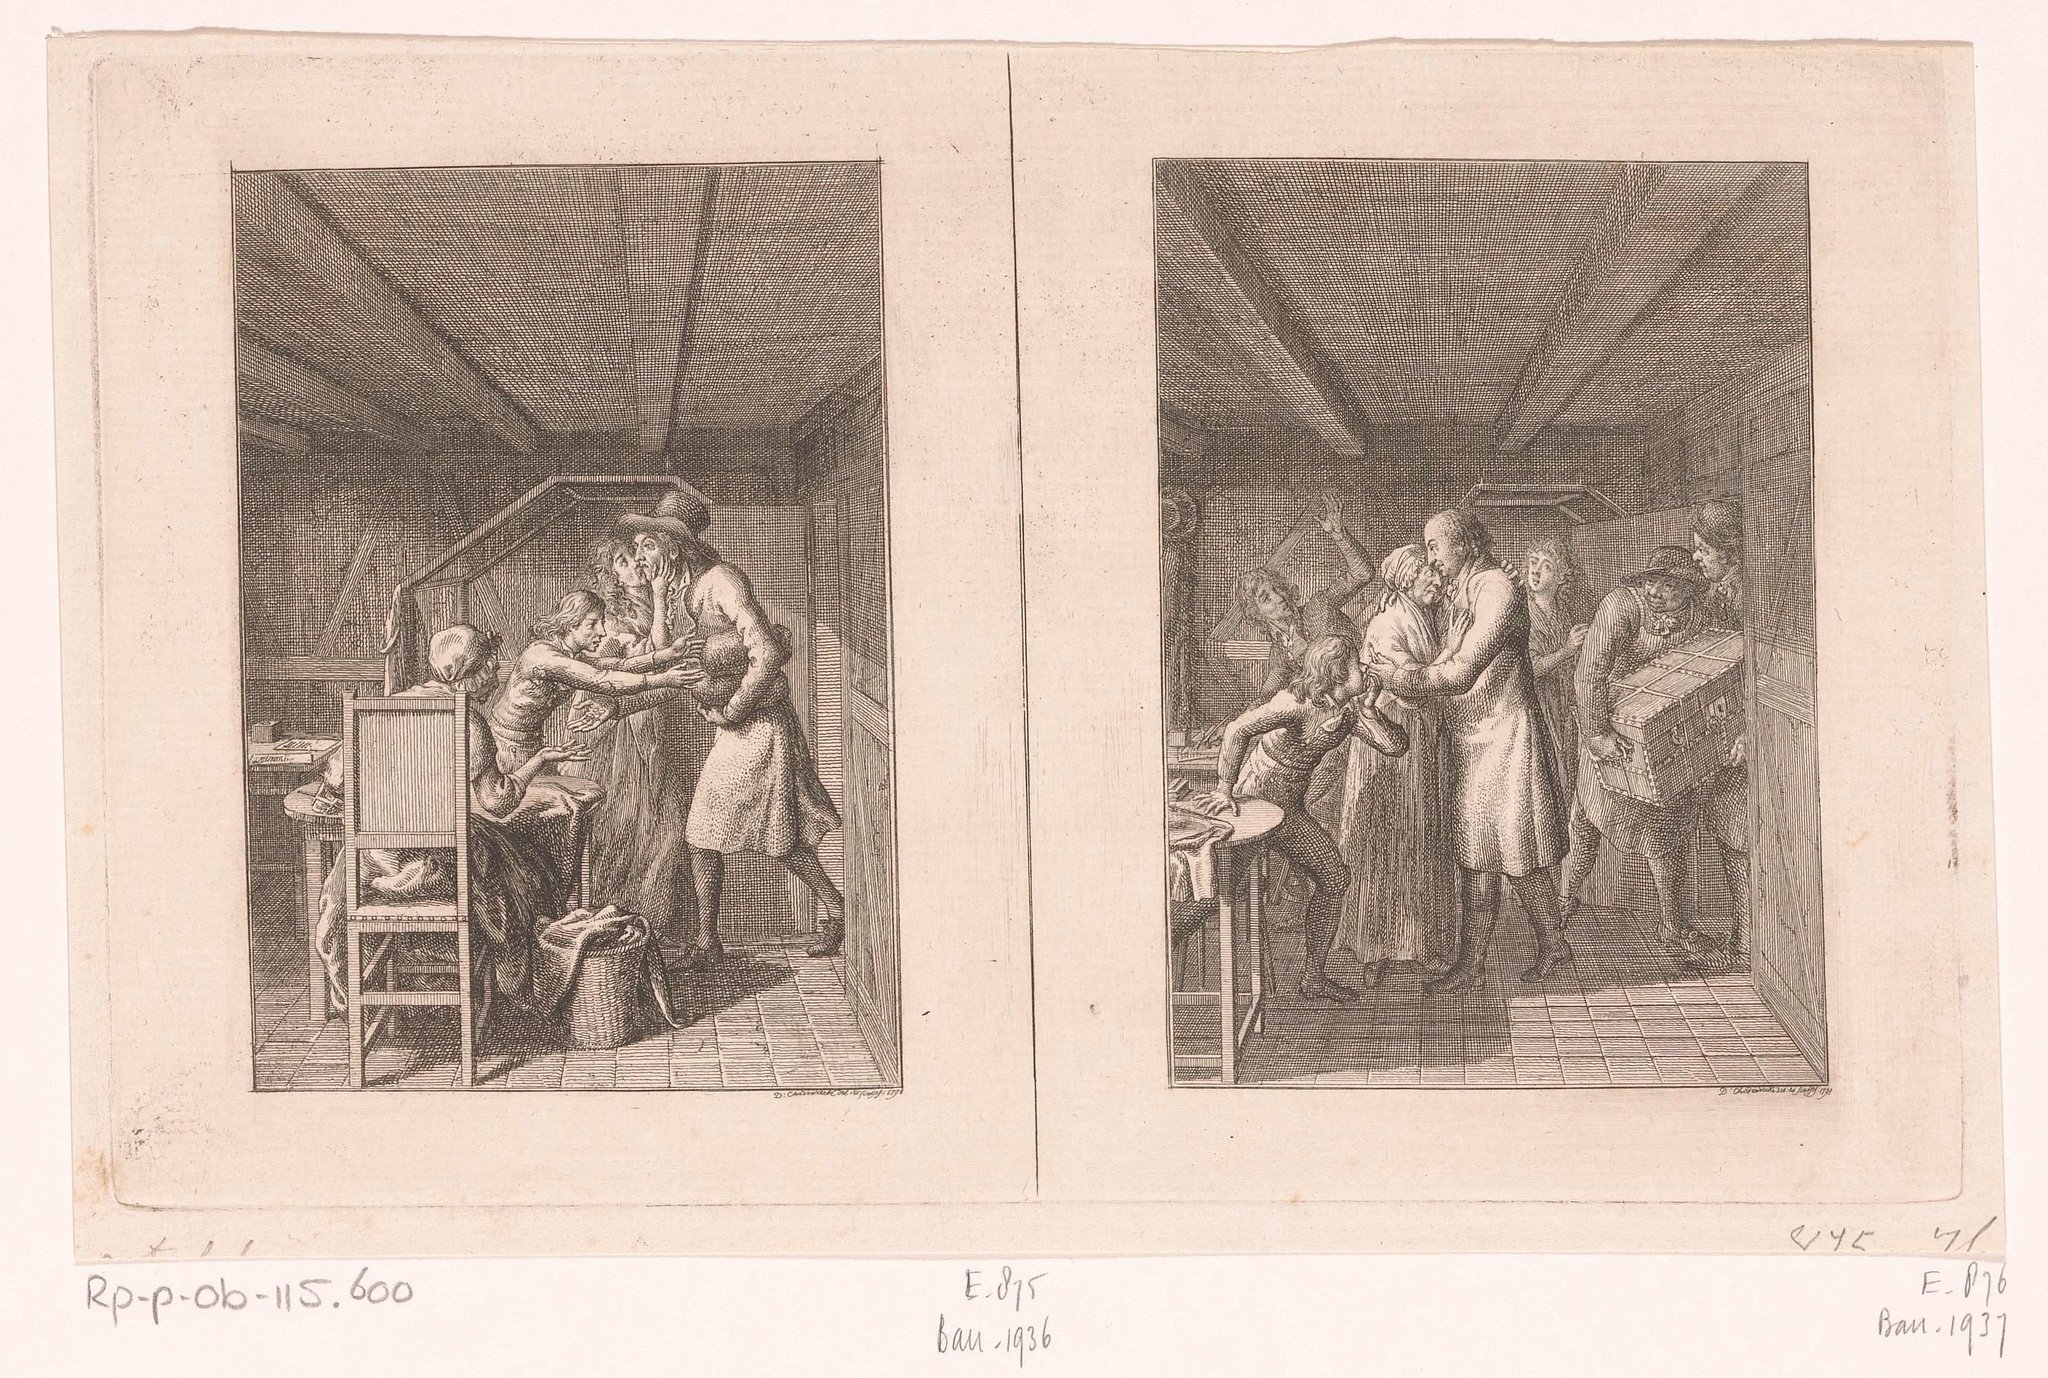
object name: print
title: Twee voorstellingen uit Familie Hellmuth van Hiemer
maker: daniel nikolaus chodowiecki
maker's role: draughtsman, print maker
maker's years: 1726-1801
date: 1798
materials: paper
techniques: etching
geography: berlin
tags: arrival and return ~ travelling, family, descendance, acquiring riches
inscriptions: collector's mark: Lugt 2228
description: Vervaardigd voor 'Familie Hellmuth' van Franz Karl Hiemer. Prent gebruikt voor: Tasschenbuch für Häusliche und Gesellschaftliche Freuden auf das Jahr 1799, 1801 und 1802 (...). Frankfurt am Main: Philipp Heinrich Guilhauman, [1797].